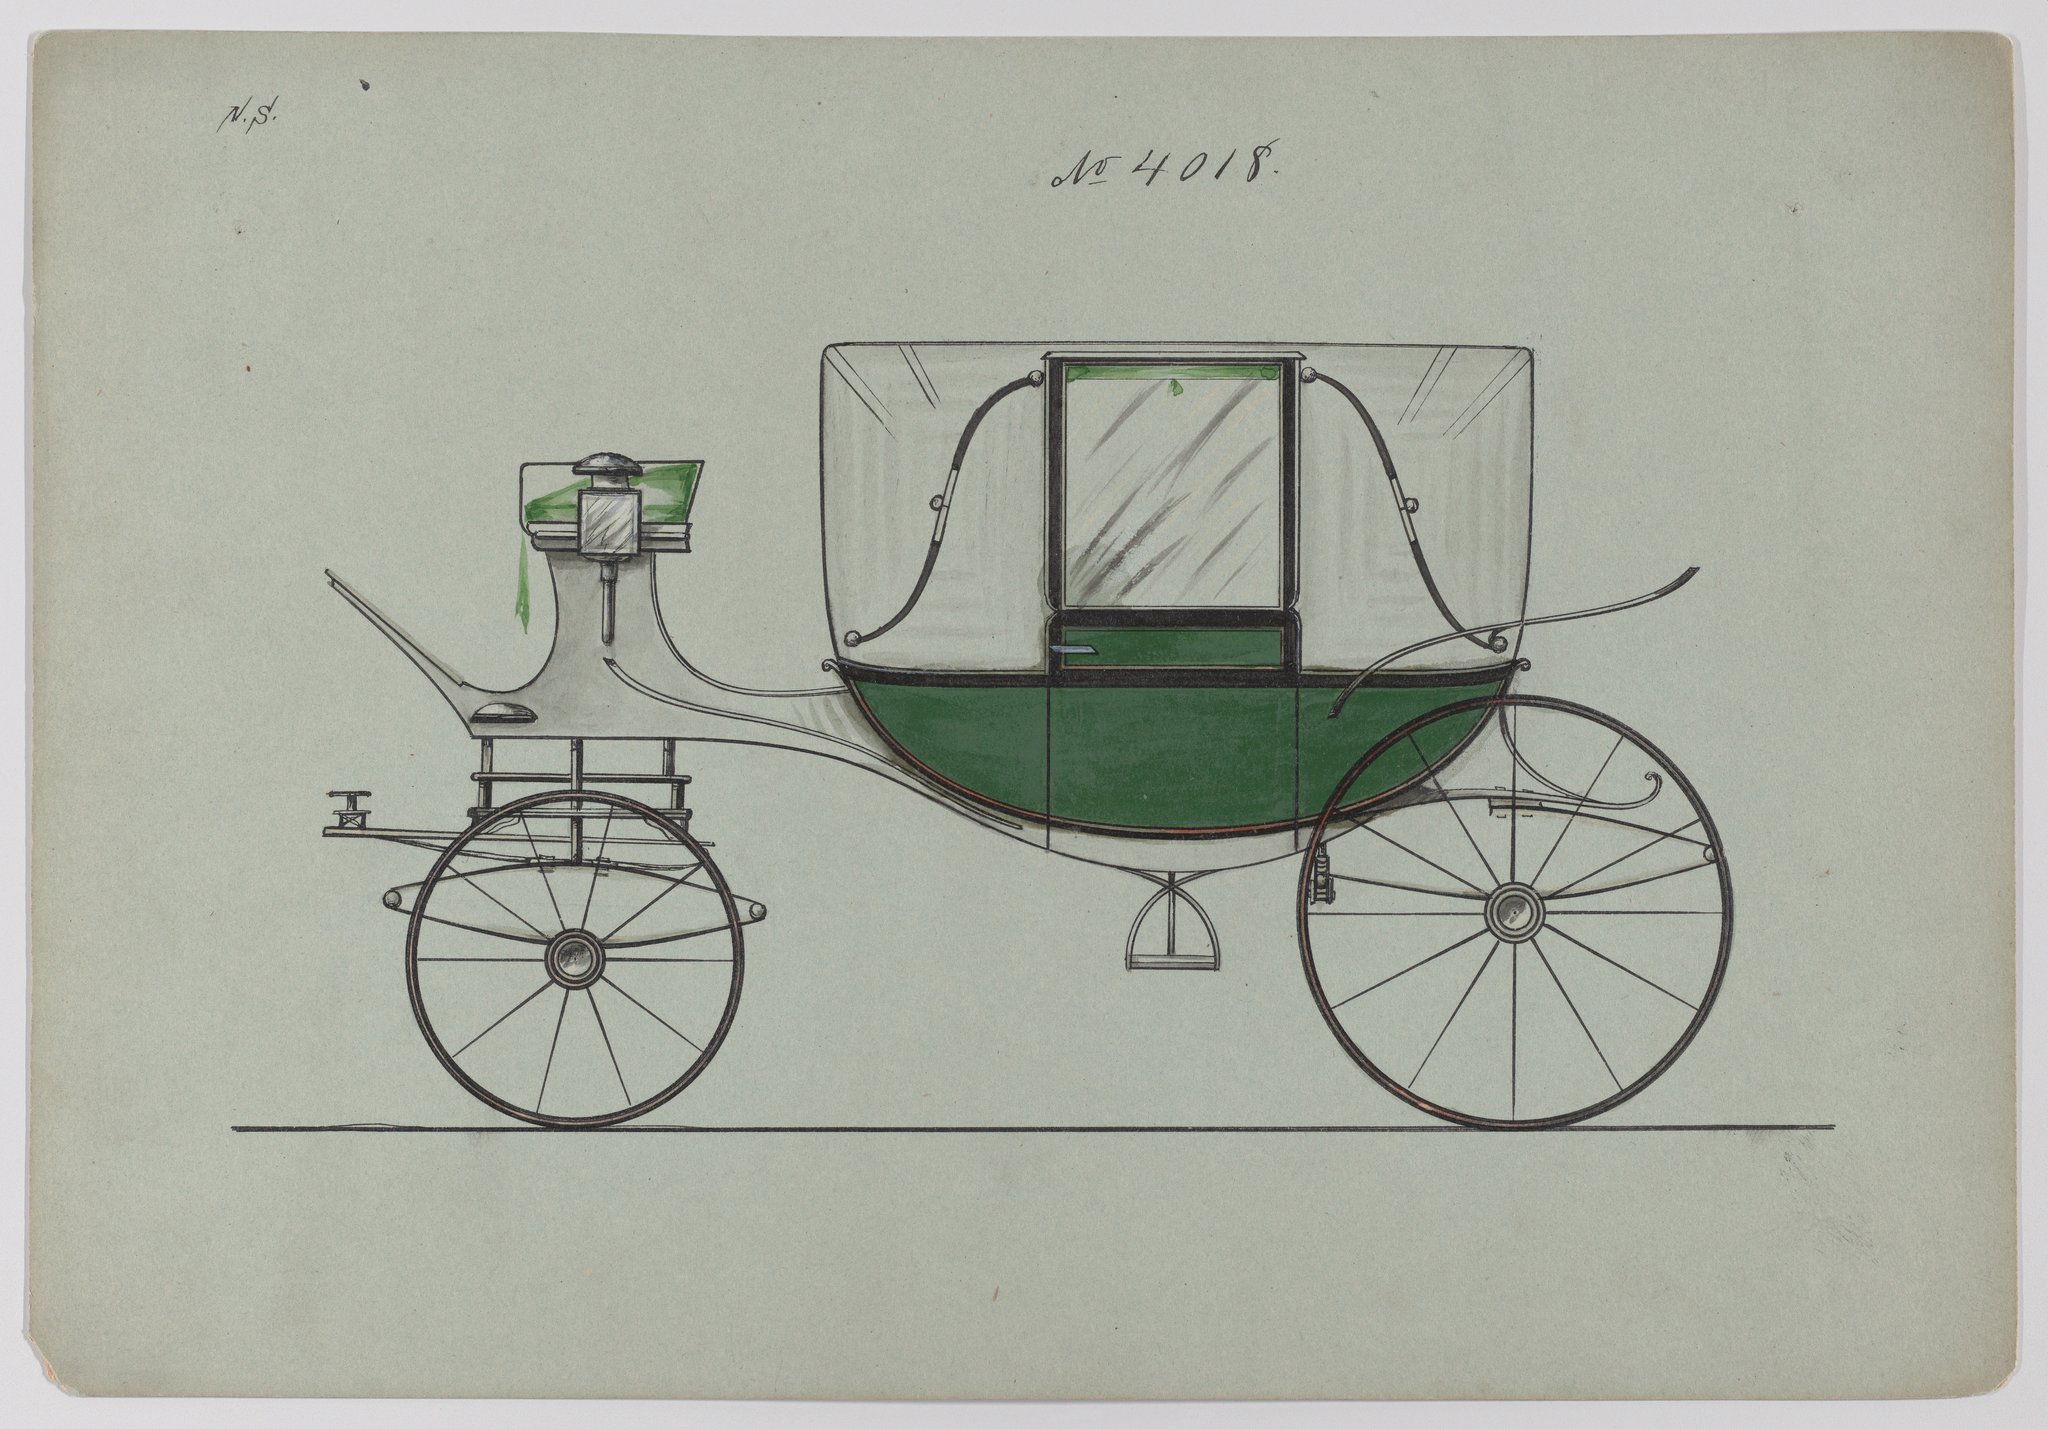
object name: drawing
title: Design for Landau, No. 4018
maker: brewster & co.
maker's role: manufacturer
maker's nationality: american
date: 1888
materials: gouache, gum arabic, ink, watercolor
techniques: pen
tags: carriages